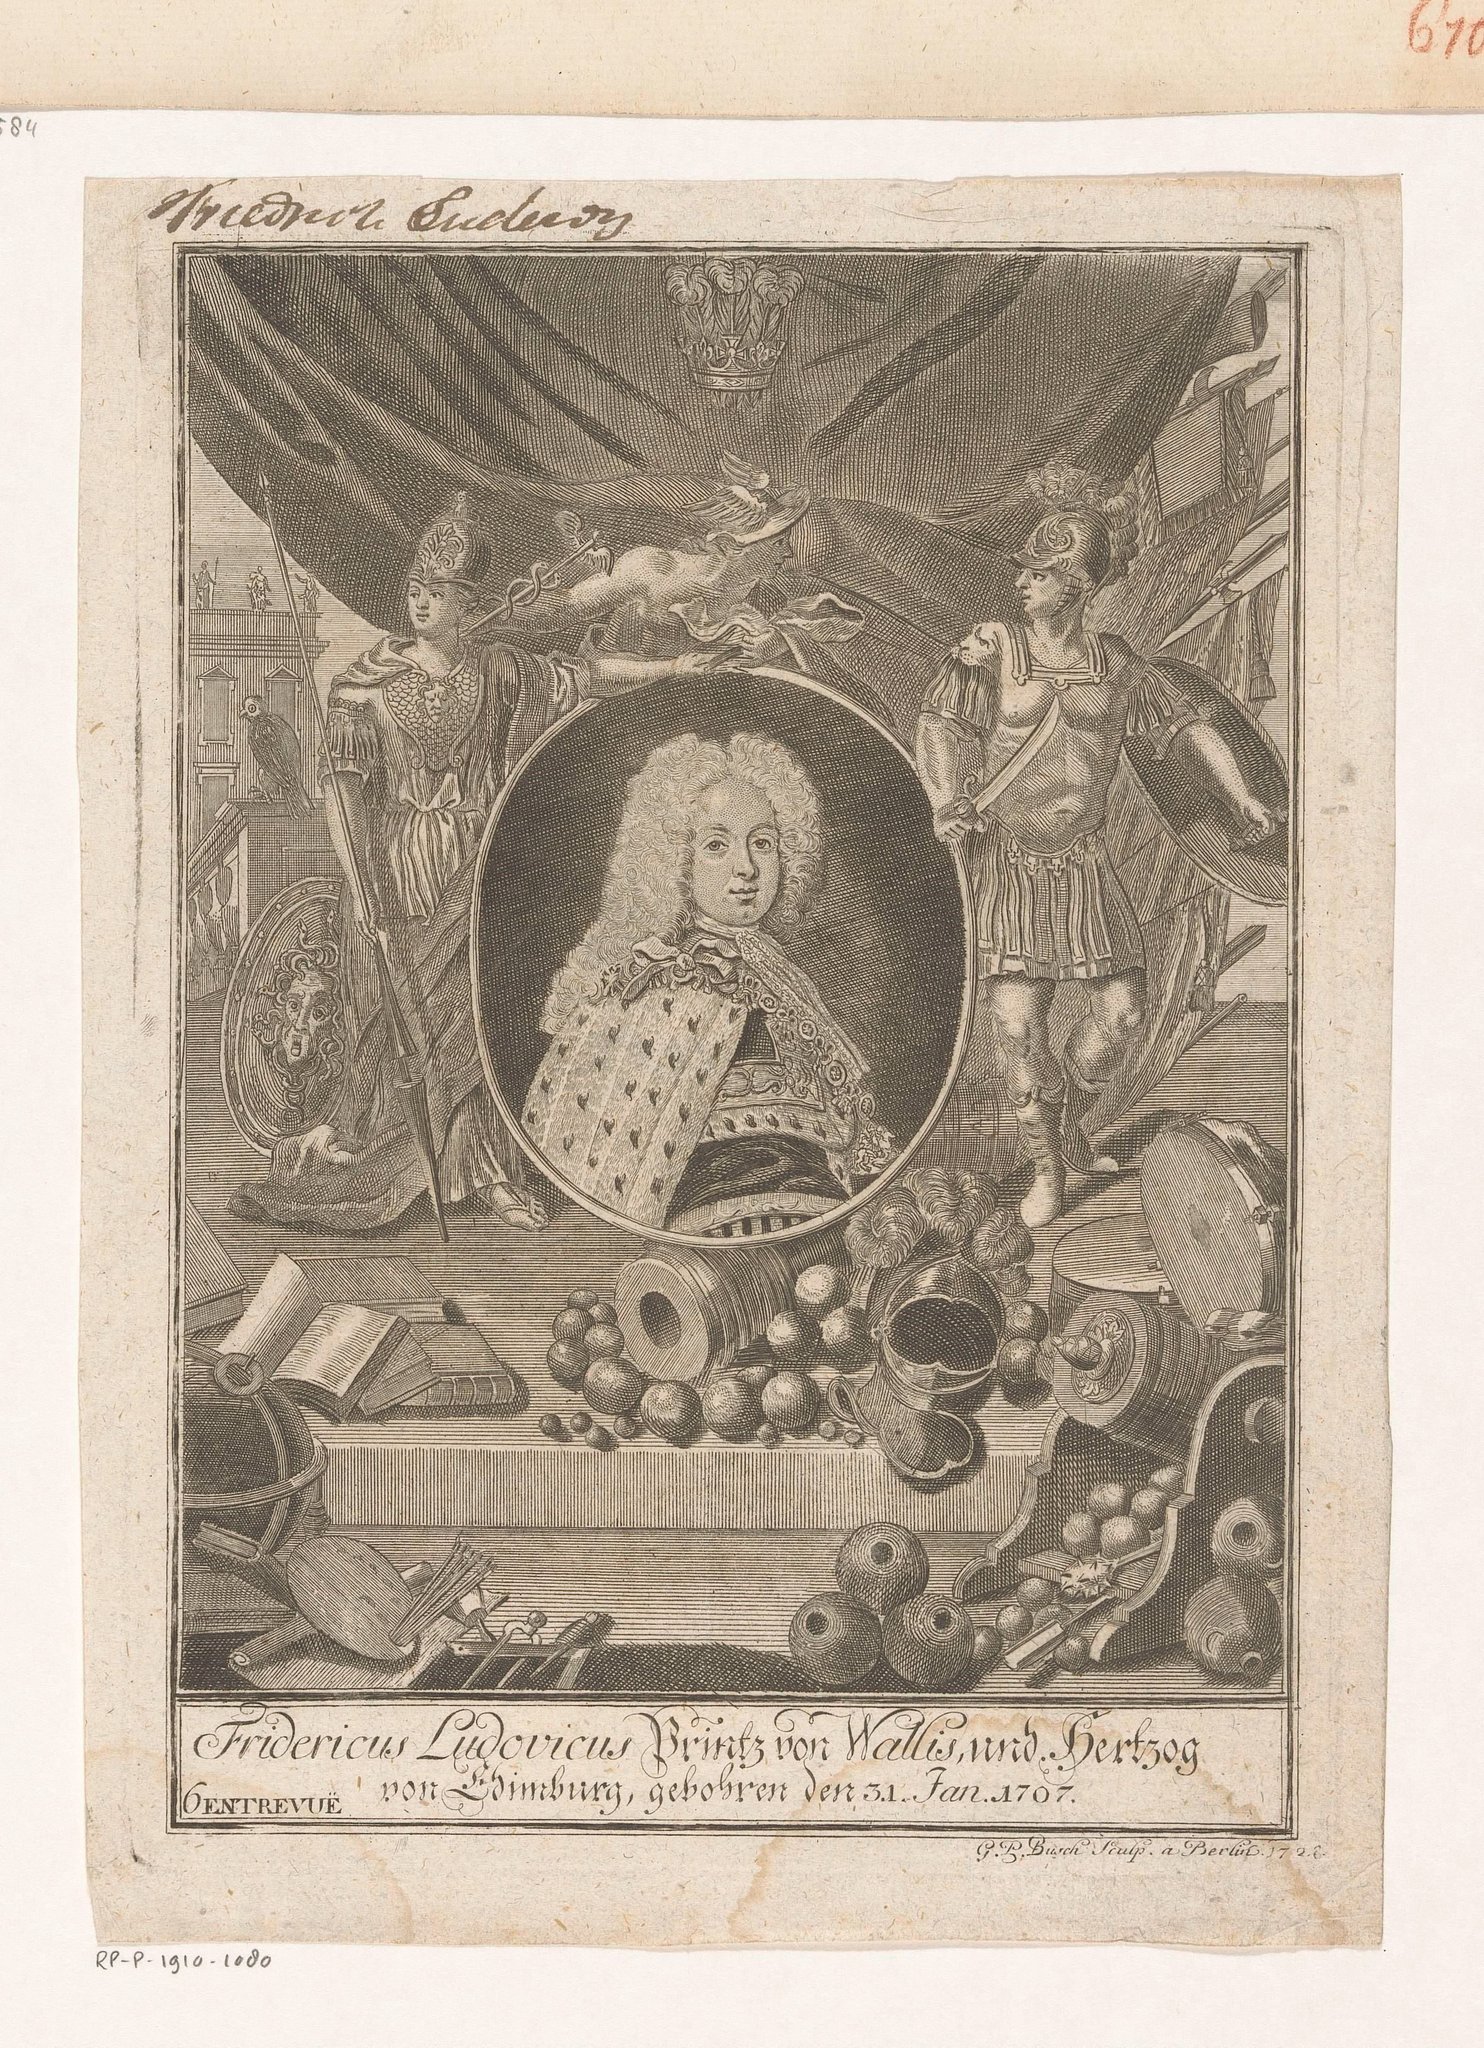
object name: print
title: Allegorische voorstelling met het portret van Frederik, prins van Wales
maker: georg paul busch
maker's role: print maker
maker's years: -1756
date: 1728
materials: paper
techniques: engraving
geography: berlin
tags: london, frederik (prins van wales), knighthood order (garter) - insignia of a knighthood order, e.g.: badge, chain, historical persons, book, firearms: cannon, mantle, gown, dress (symbol of sovereignty), specific aspects, allegorical aspects of minerva; minerva as patroness, specific aspects, allegorical aspects of mercury; mercury as patron, specific aspects, allegorical aspects of mars; mars as patron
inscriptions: collector's mark: Lugt 2228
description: Rond het portret Minerva, Mercurius en Mars. Op de voorgrond links boeken en gereedschappen van een kunstenaar; rechts een helm en een kanon met kogels. Linksonder genummerd: 6 entrevuë.